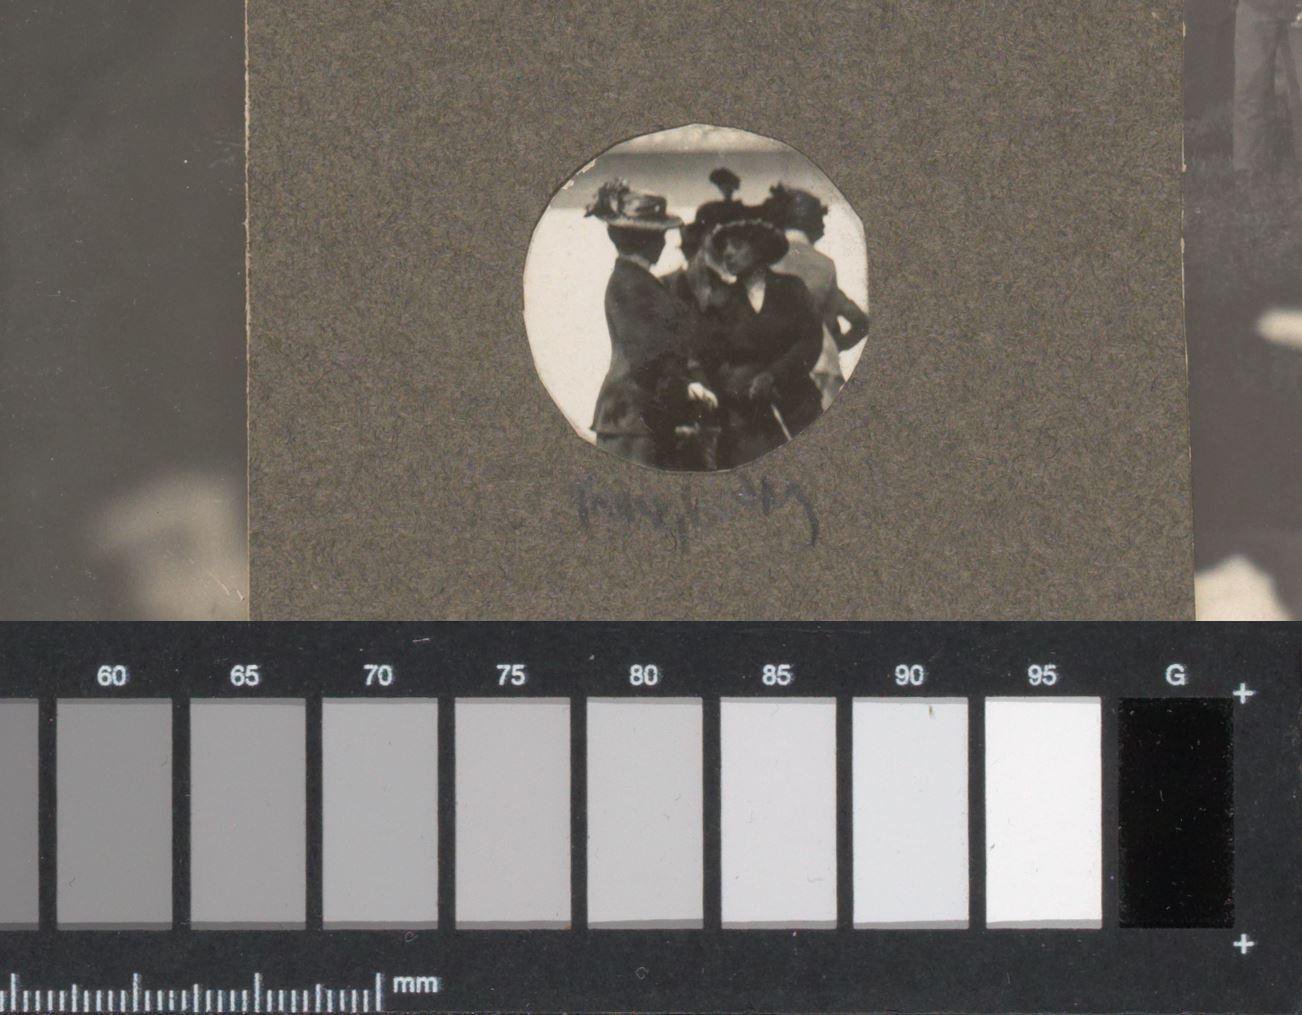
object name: album leaf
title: Ruitertafereel op Koninklijke Houtvesterij Het Loo: vrouwen met hoeden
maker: Anonymous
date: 1900-1925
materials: photographic support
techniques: gelatin silver print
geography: het loo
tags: hunting, chase, hunting-ground, head-gear: hat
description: Onderdeel van Fotoalbum van de heer Brams, opperhoutvester van koningin Wilhelmina op Koninklijke Houtvesterij Het Loo.